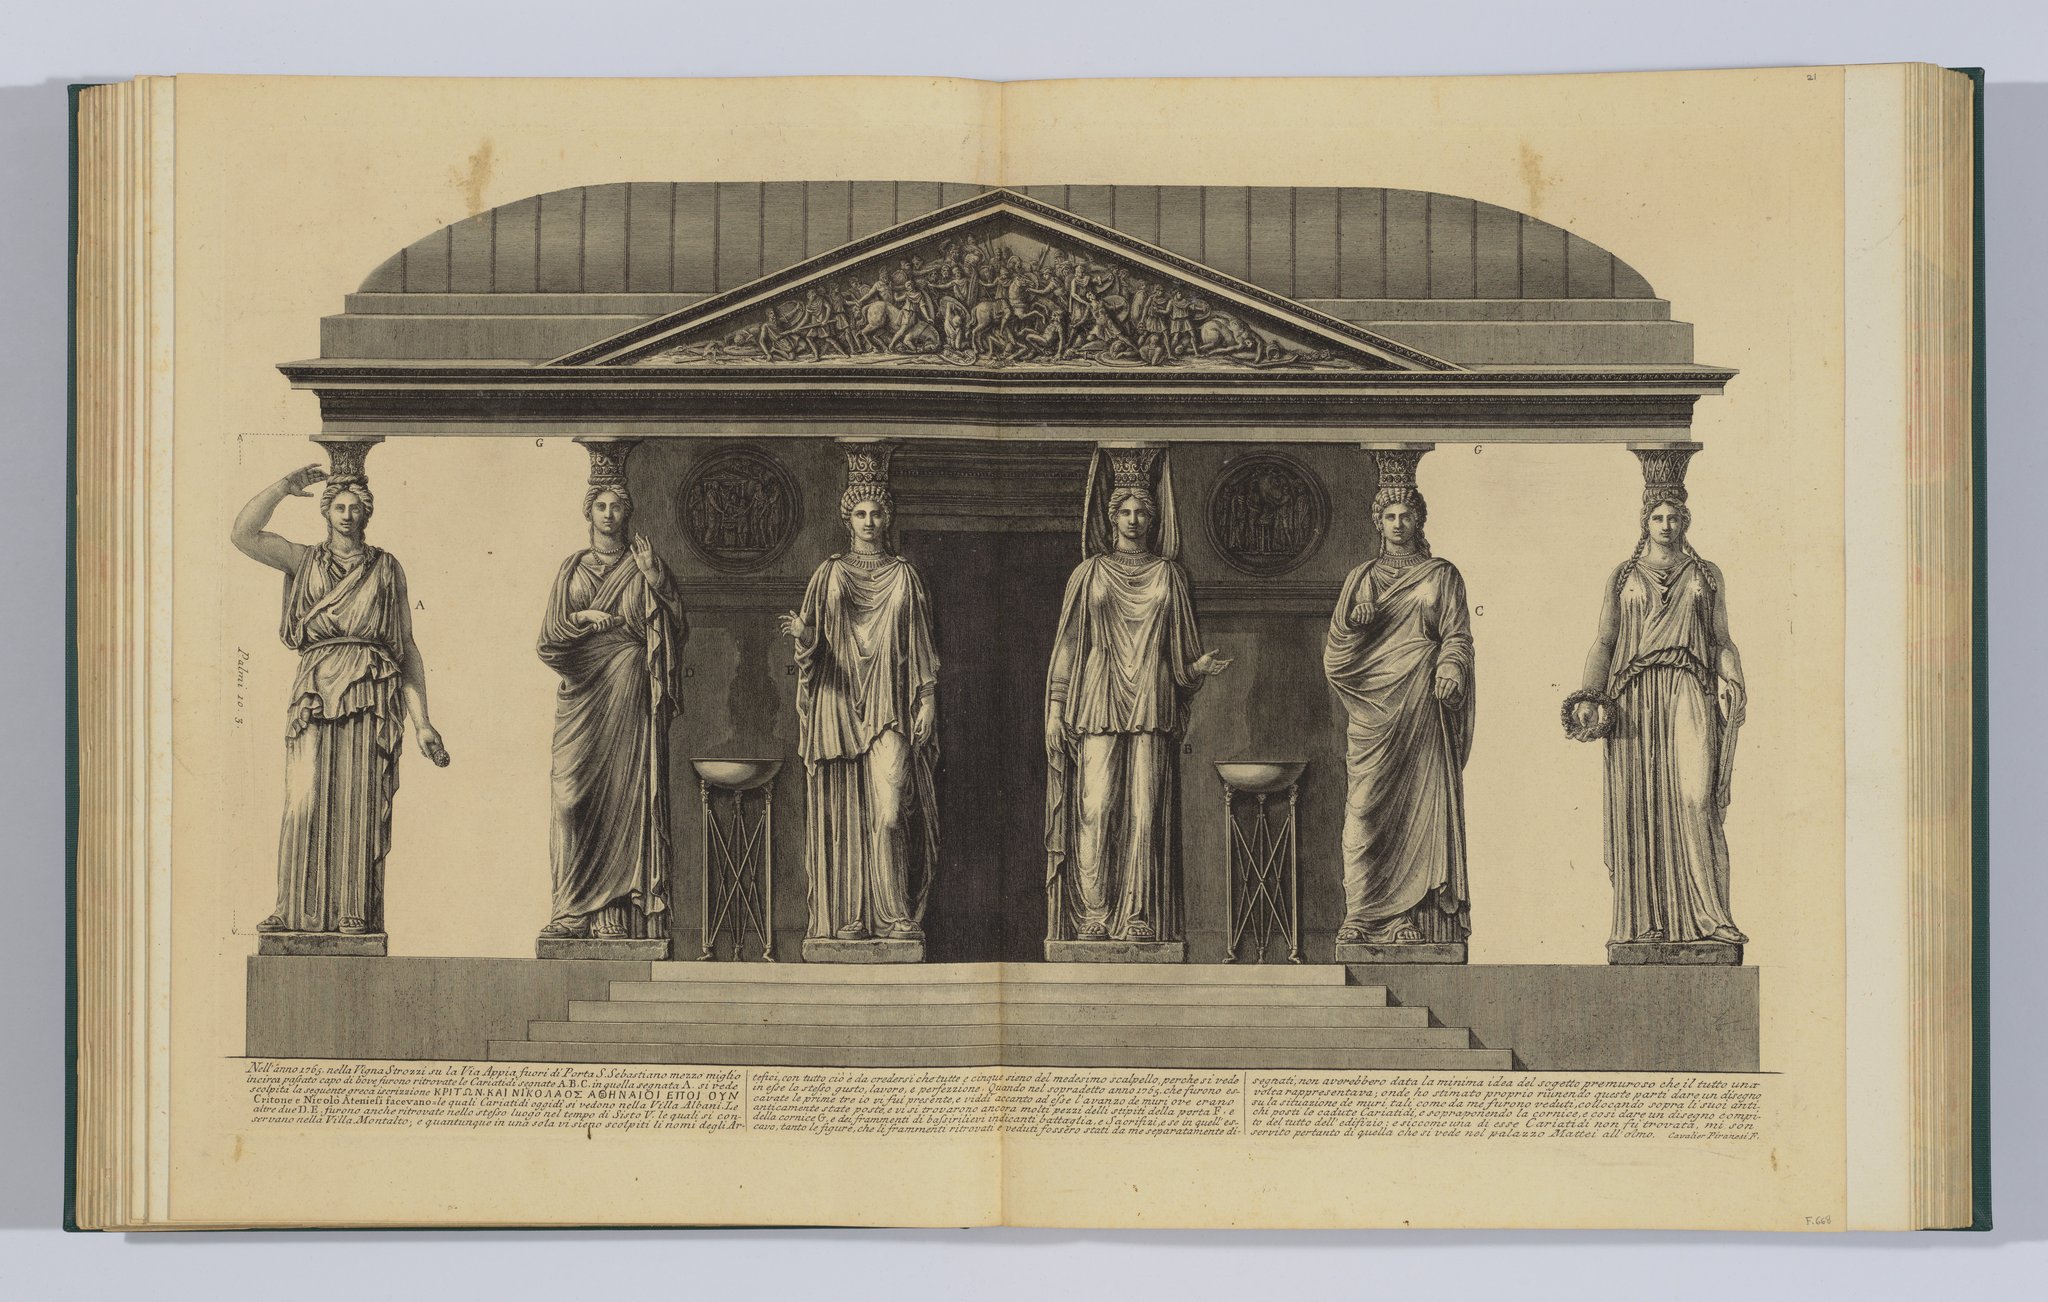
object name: print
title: Group of caryatids, from "Vasi, candelabri, cippi, sarcofagi, tripodi, lucerne, ed ornamenti antichi disegnati ed incisi dal Cav. Gio. Batt. Piranesi, Vol. II" (Vases, candelabra, grave stones, sarcophagi, tripods, lamps, and ornaments designed and etched by Cavalieri Giovanni Battista Piranesi)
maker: giovanni battista piranesi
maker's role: artist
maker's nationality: italian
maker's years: 1720-1778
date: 1778-1780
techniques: etching